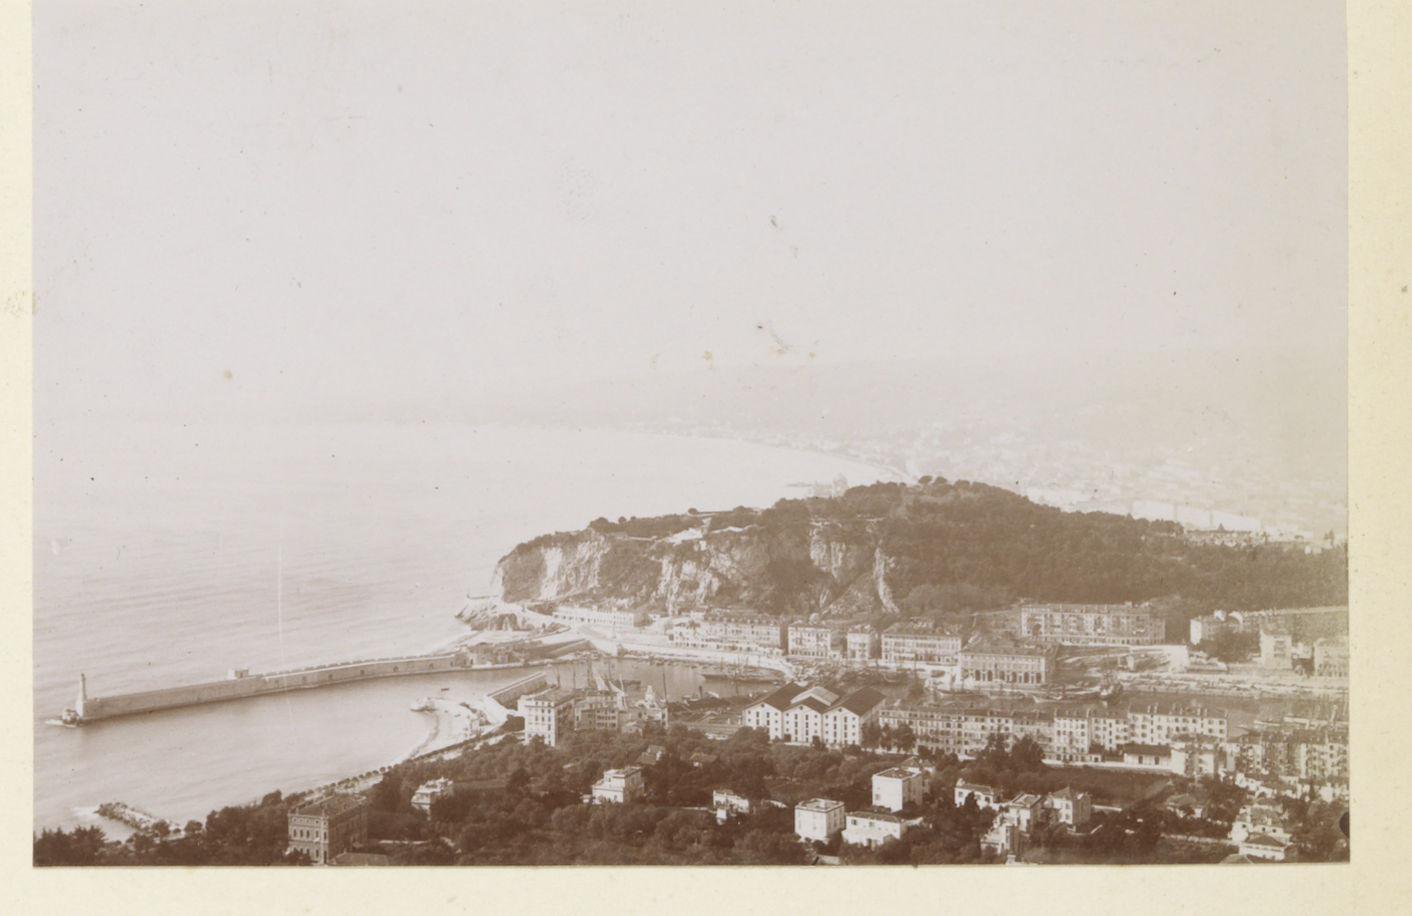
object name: photograph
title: Gezicht op een haveningang met vuurtoren, vermoedelijk aan de kust van Zuid-Frankrijk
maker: Anonymous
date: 1900-1910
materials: paper, photographic support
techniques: daylight paper print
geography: southern france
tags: lighthouse, lightship, coast, prospect of city, town panorama, silhouette of city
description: Onderdeel van Fotoalbum van een Franse amateurfotograaf met opnames van een familie, distilleerderij Delizy & Doistau Fils, het leger en bezienswaardigheden in Frankrijk.